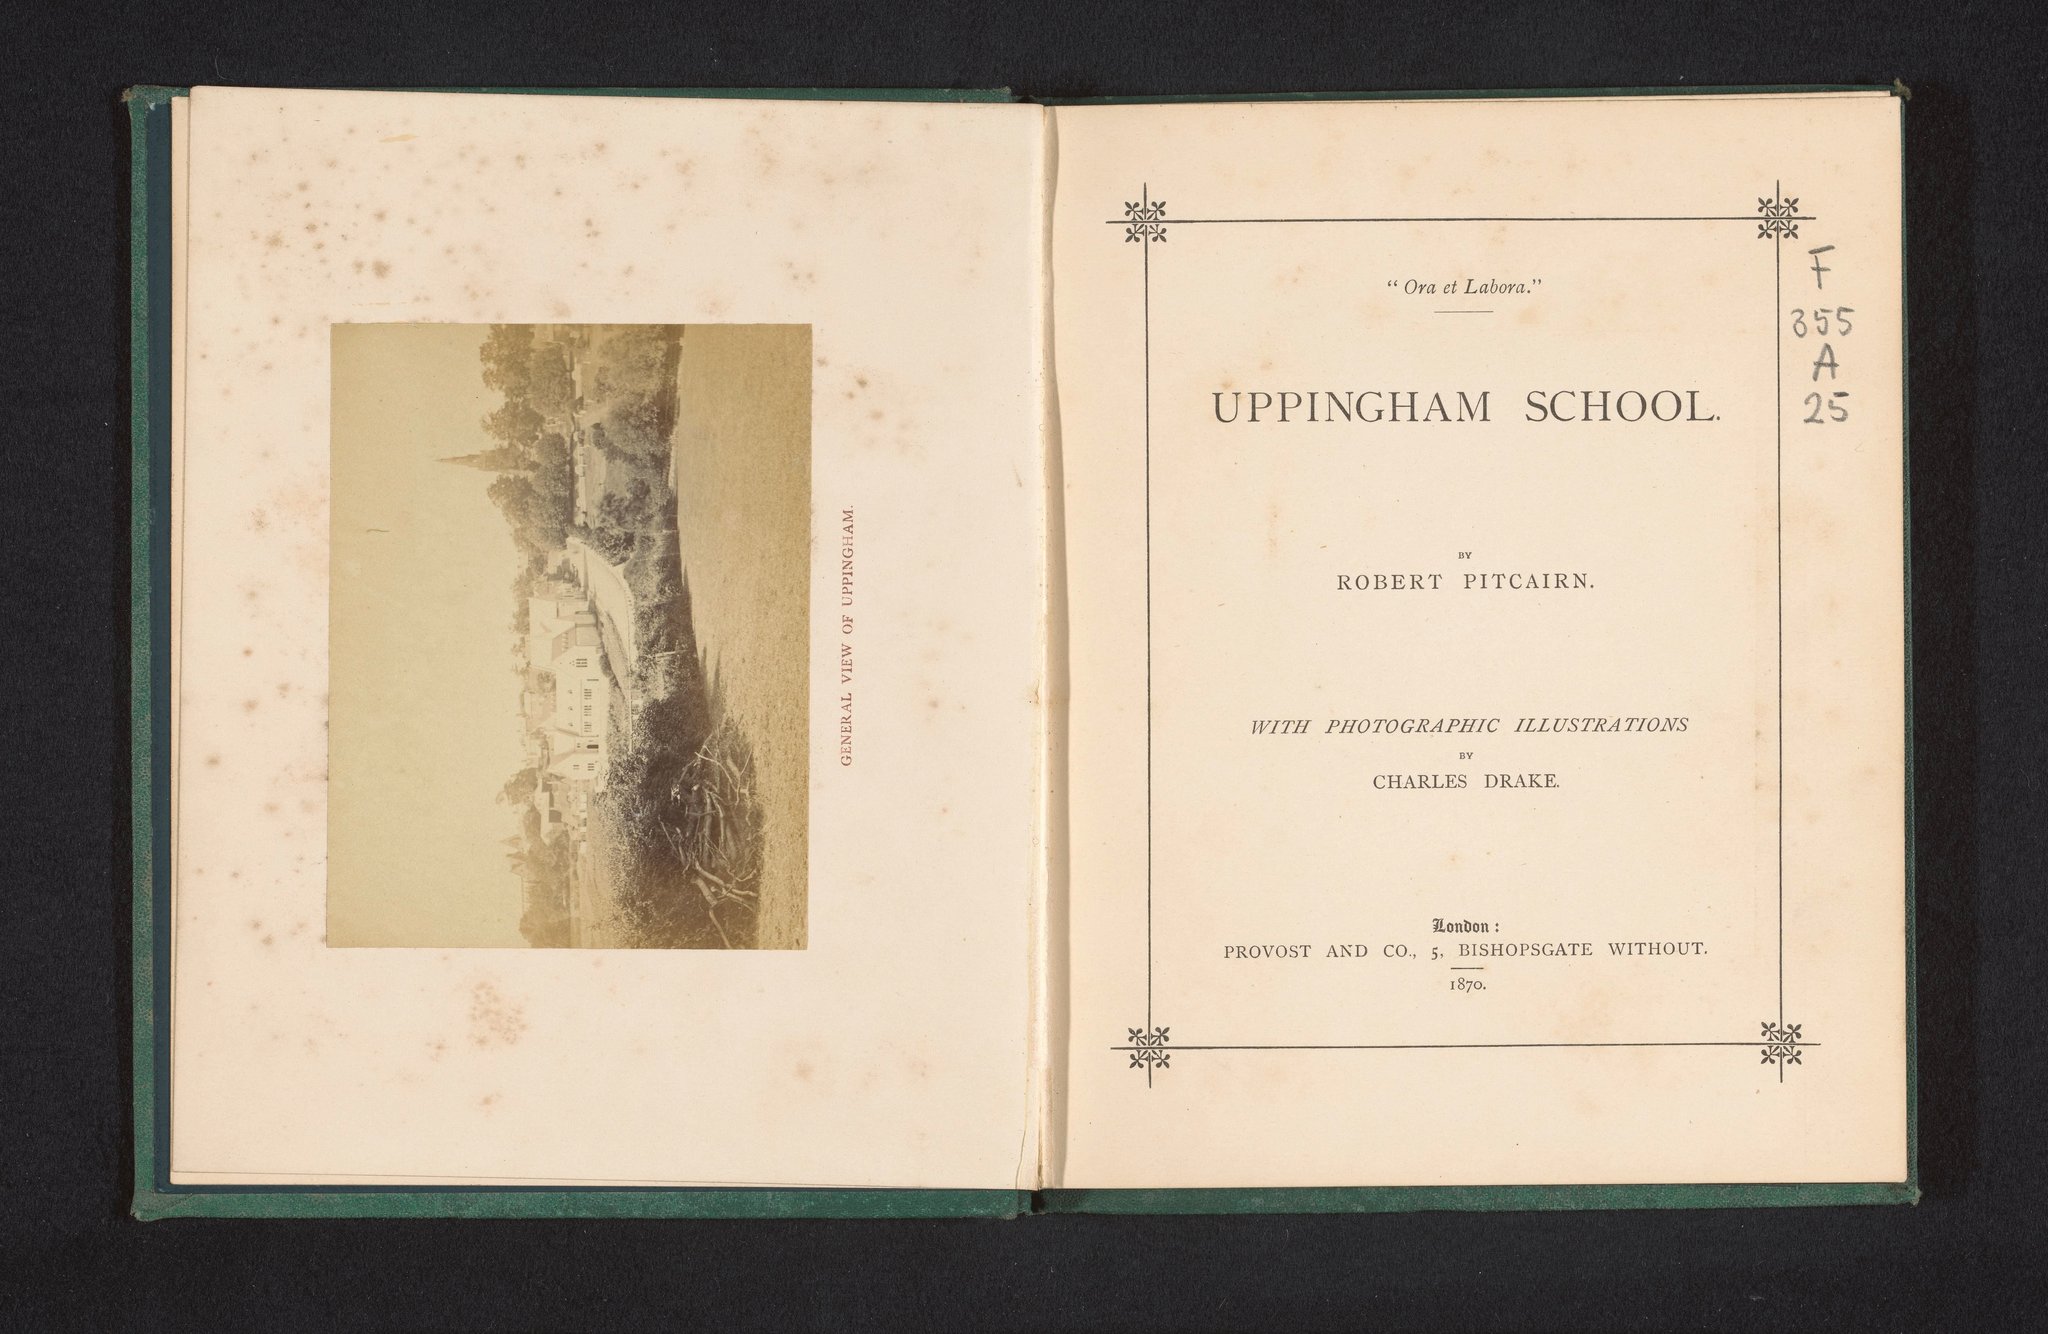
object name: book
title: Uppingham School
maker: robert pitcairn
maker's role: schrijver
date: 1870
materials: cardboard, linen, paper, photographic support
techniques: albumen print, gelatin silver print, printing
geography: london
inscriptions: inscription: ‘G. H. Wollarton from Edward Ohring July 1870 W.W. Parr from G.H. Wollarton 10 Nov. 1906.’, inscription: ‘ex libris SFJ’